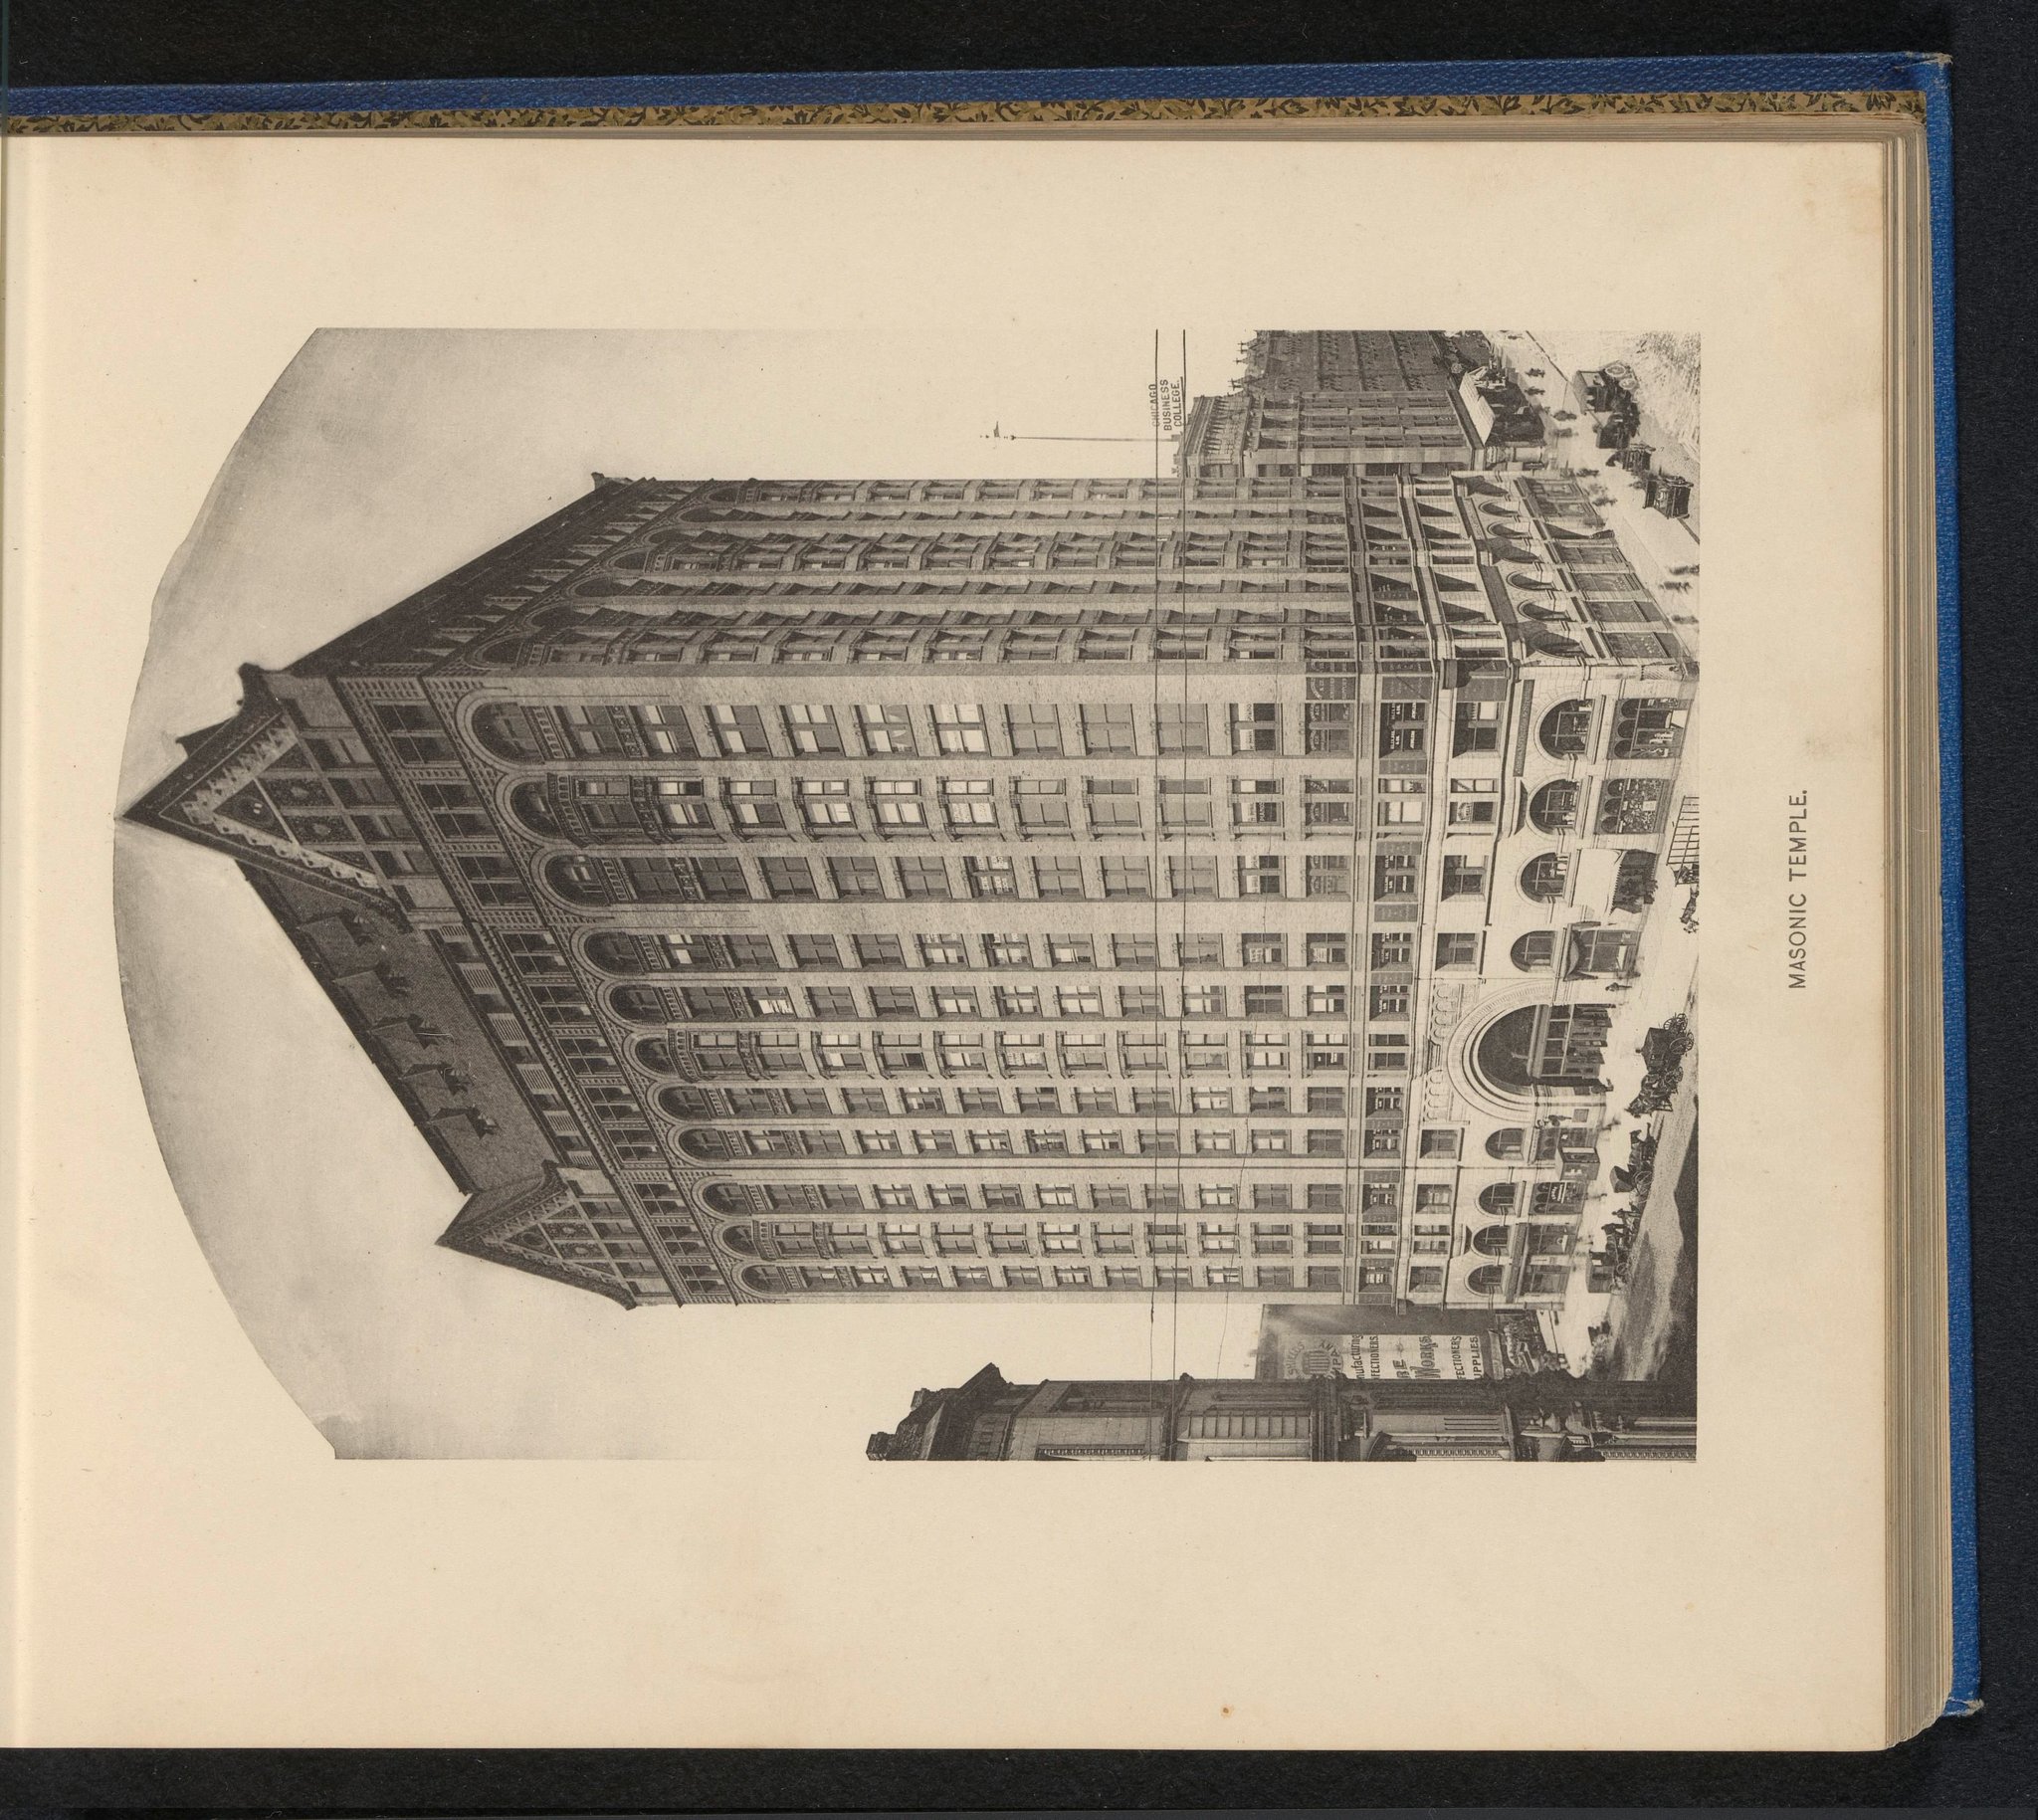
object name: page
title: Masonic Temple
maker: Anonymous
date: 1893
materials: paper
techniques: photograph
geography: chicago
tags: skyscraper